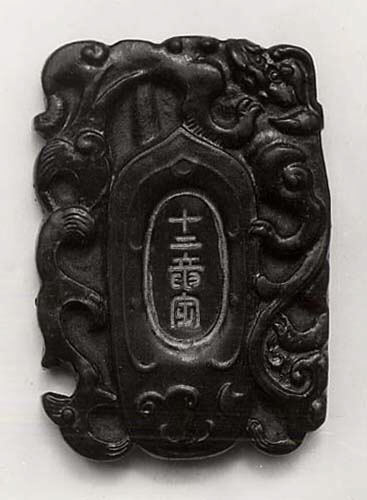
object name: ink tablet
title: The Twelve Dragon Guests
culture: chinese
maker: hu xingju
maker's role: artist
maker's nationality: chinese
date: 1662-1722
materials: ink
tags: dragons